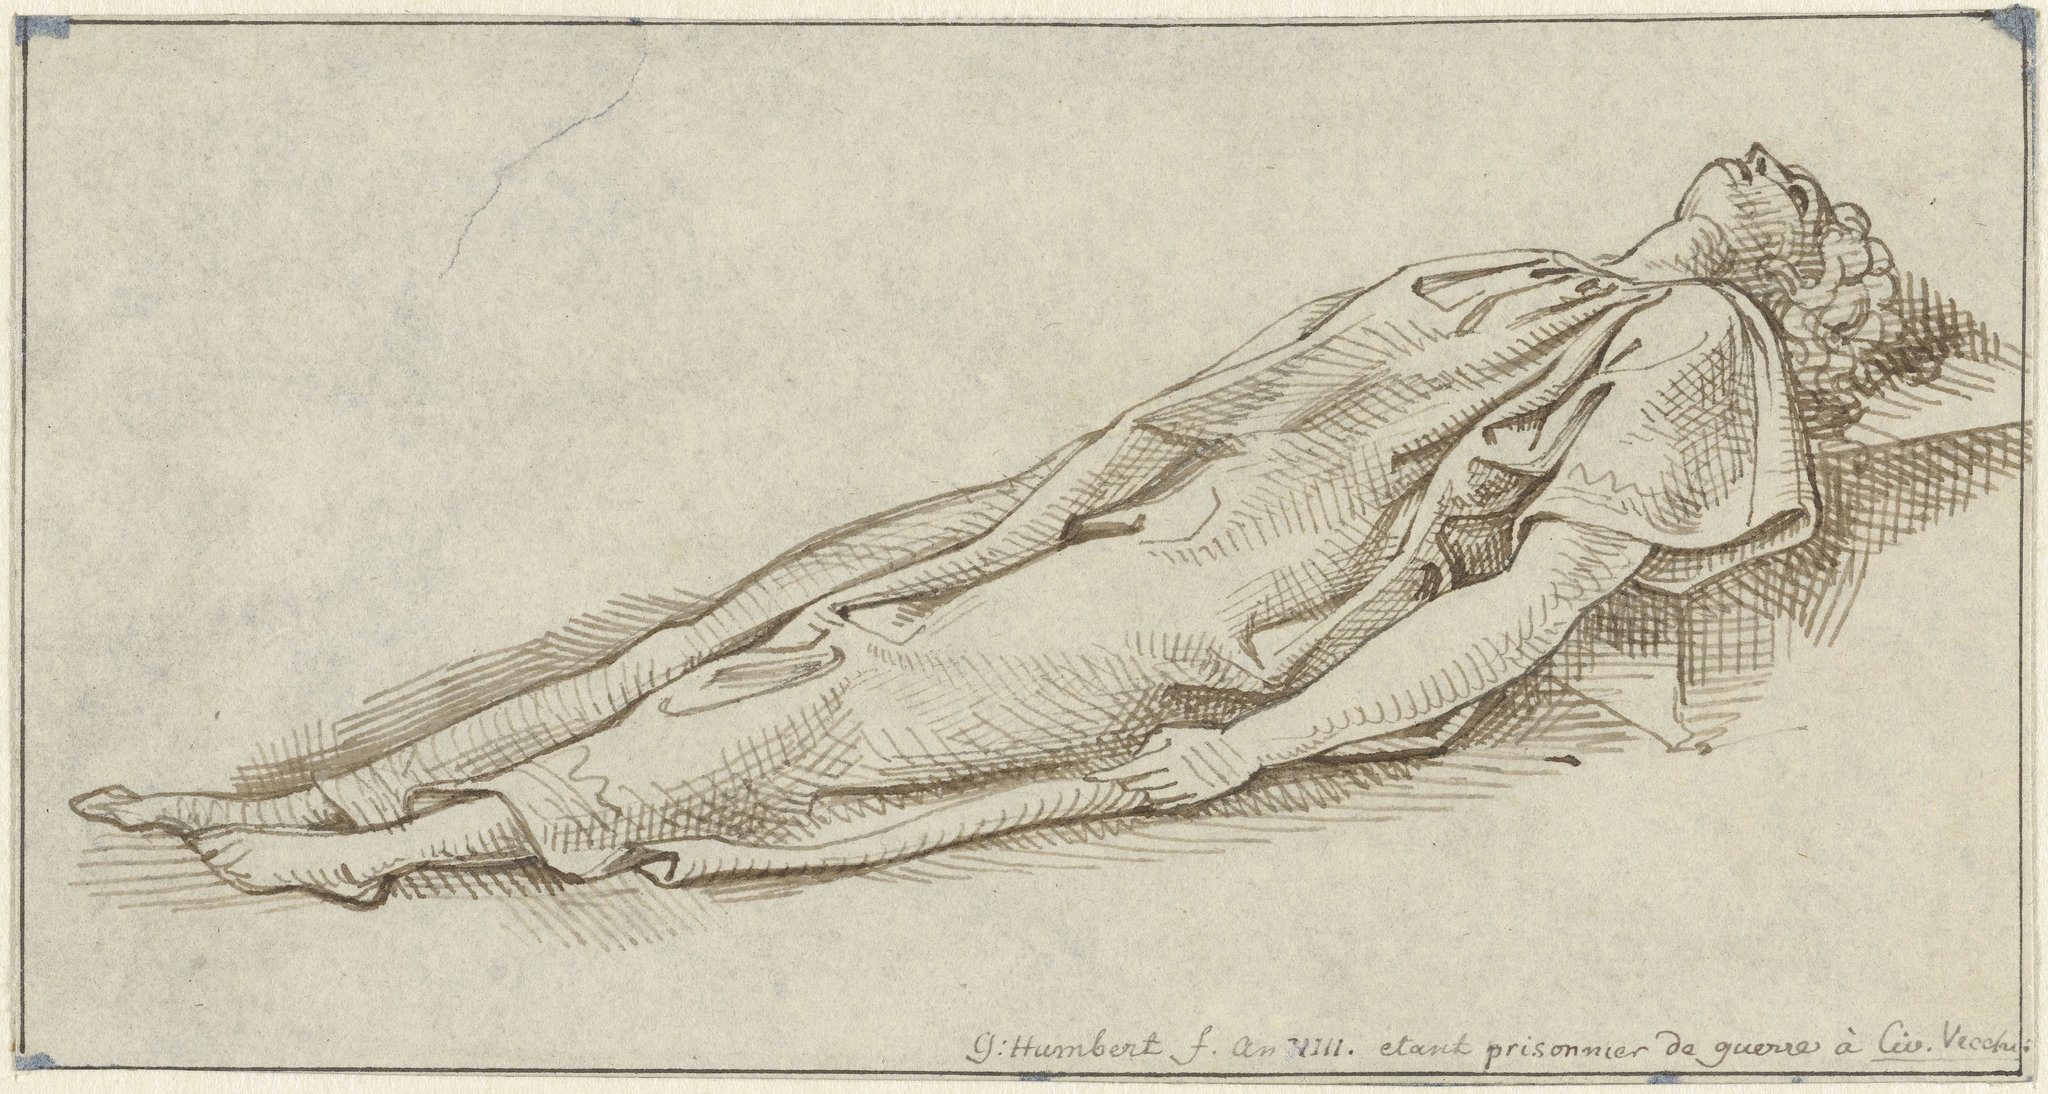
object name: drawing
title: Liggende figuur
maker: david pièrre giottino humbert de superville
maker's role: draughtsman, painter, print maker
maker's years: 1770-1849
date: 1780-1849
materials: ink, paper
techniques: pen